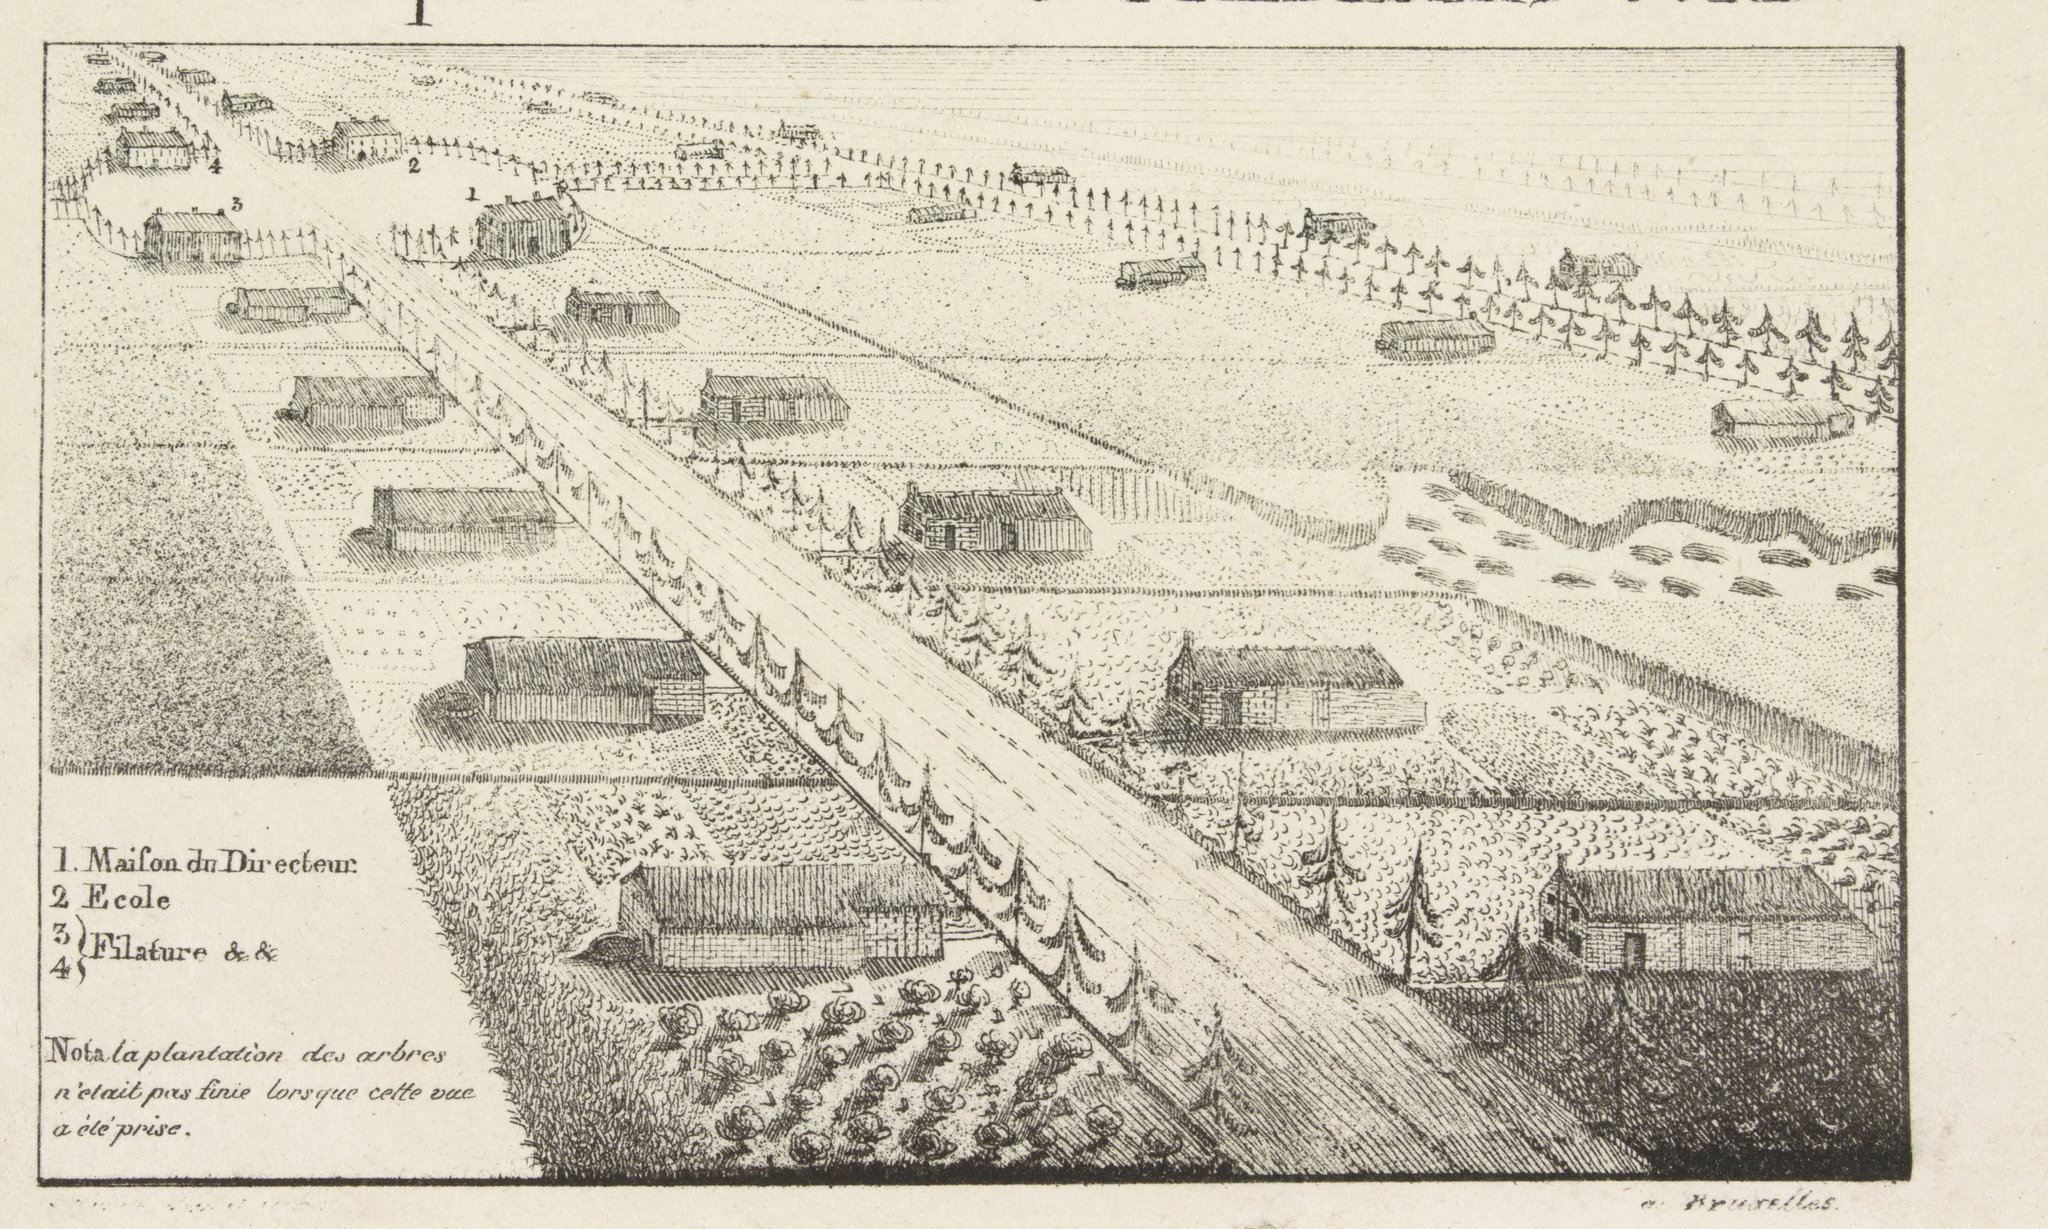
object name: print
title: De kolonie Frederiksoord, 1818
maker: Anonymous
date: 1819-1821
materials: paper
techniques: lithograph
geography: brussels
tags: public welfare, rural housing, e.g. country-house, villa, cottage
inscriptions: collector's mark: Lugt 2228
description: Gebruikt als illustratie in: Johannes van den Bosch [vertaling: Charles Louis Guillaume Josephe de Keverberg], De la Colonie de Frederiks-oord et de ses moyens de subvenir aux besoins de l'indigence par le défrichement des terres vagues et incultes / trad. d'un ms. de J. van den Bosch par le baron De Keverberg avec préface du traducteur. Gent: Houdin, 1821.